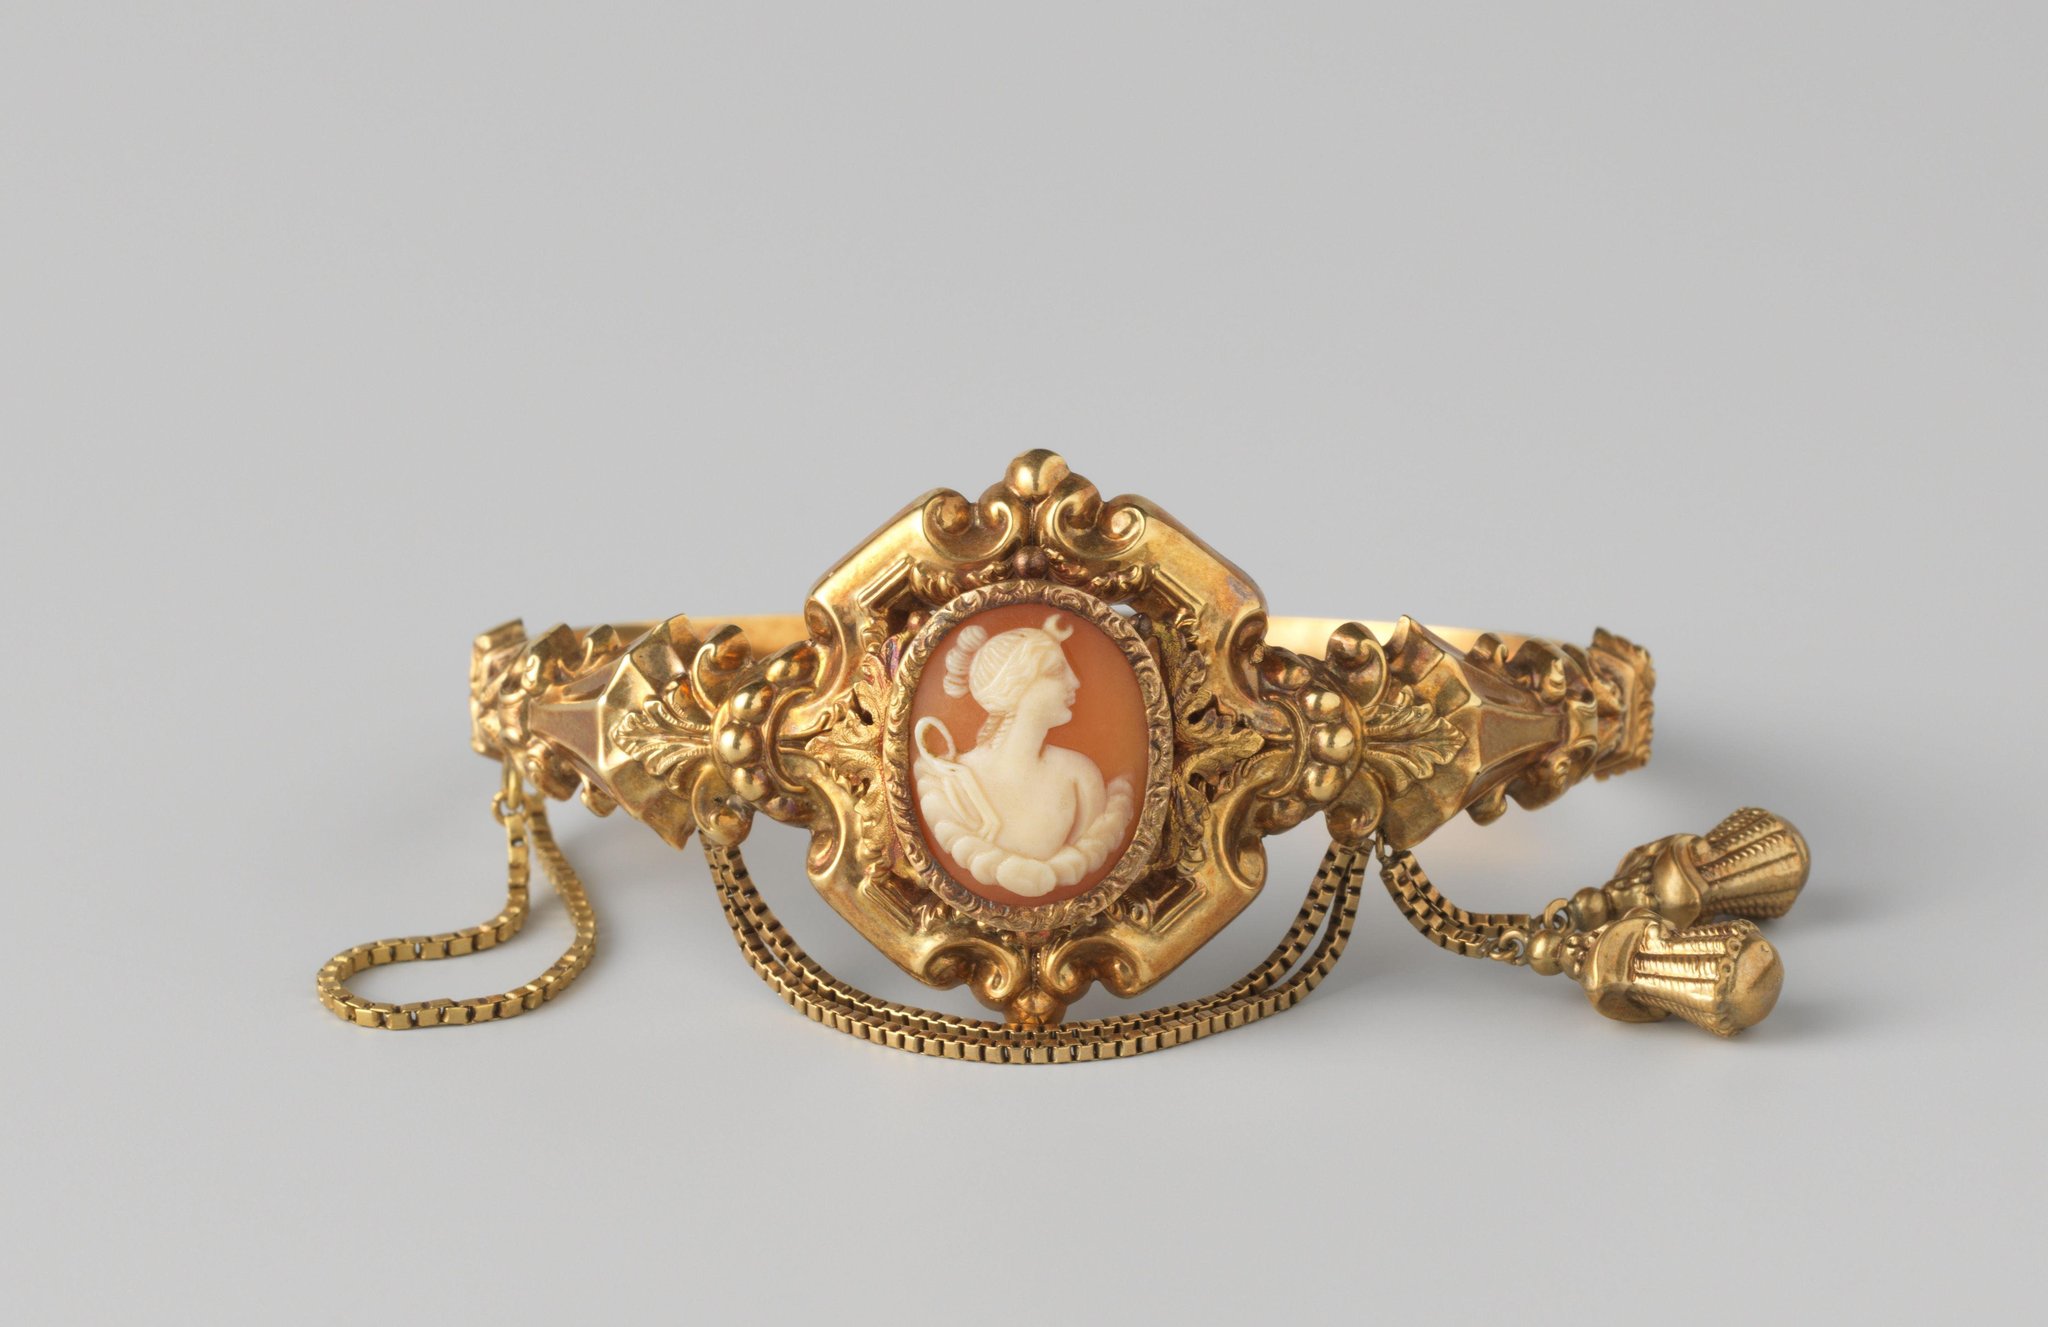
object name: bracelet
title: Armband van holgeslagen goud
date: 1800-1900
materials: gold, silver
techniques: gilding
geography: germany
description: In het midden, binnen een cartouche een camee met Dianabuste in verguld zilveren vatting. Als aanhangers gouden kettinkjes met twee kwastknoppen.